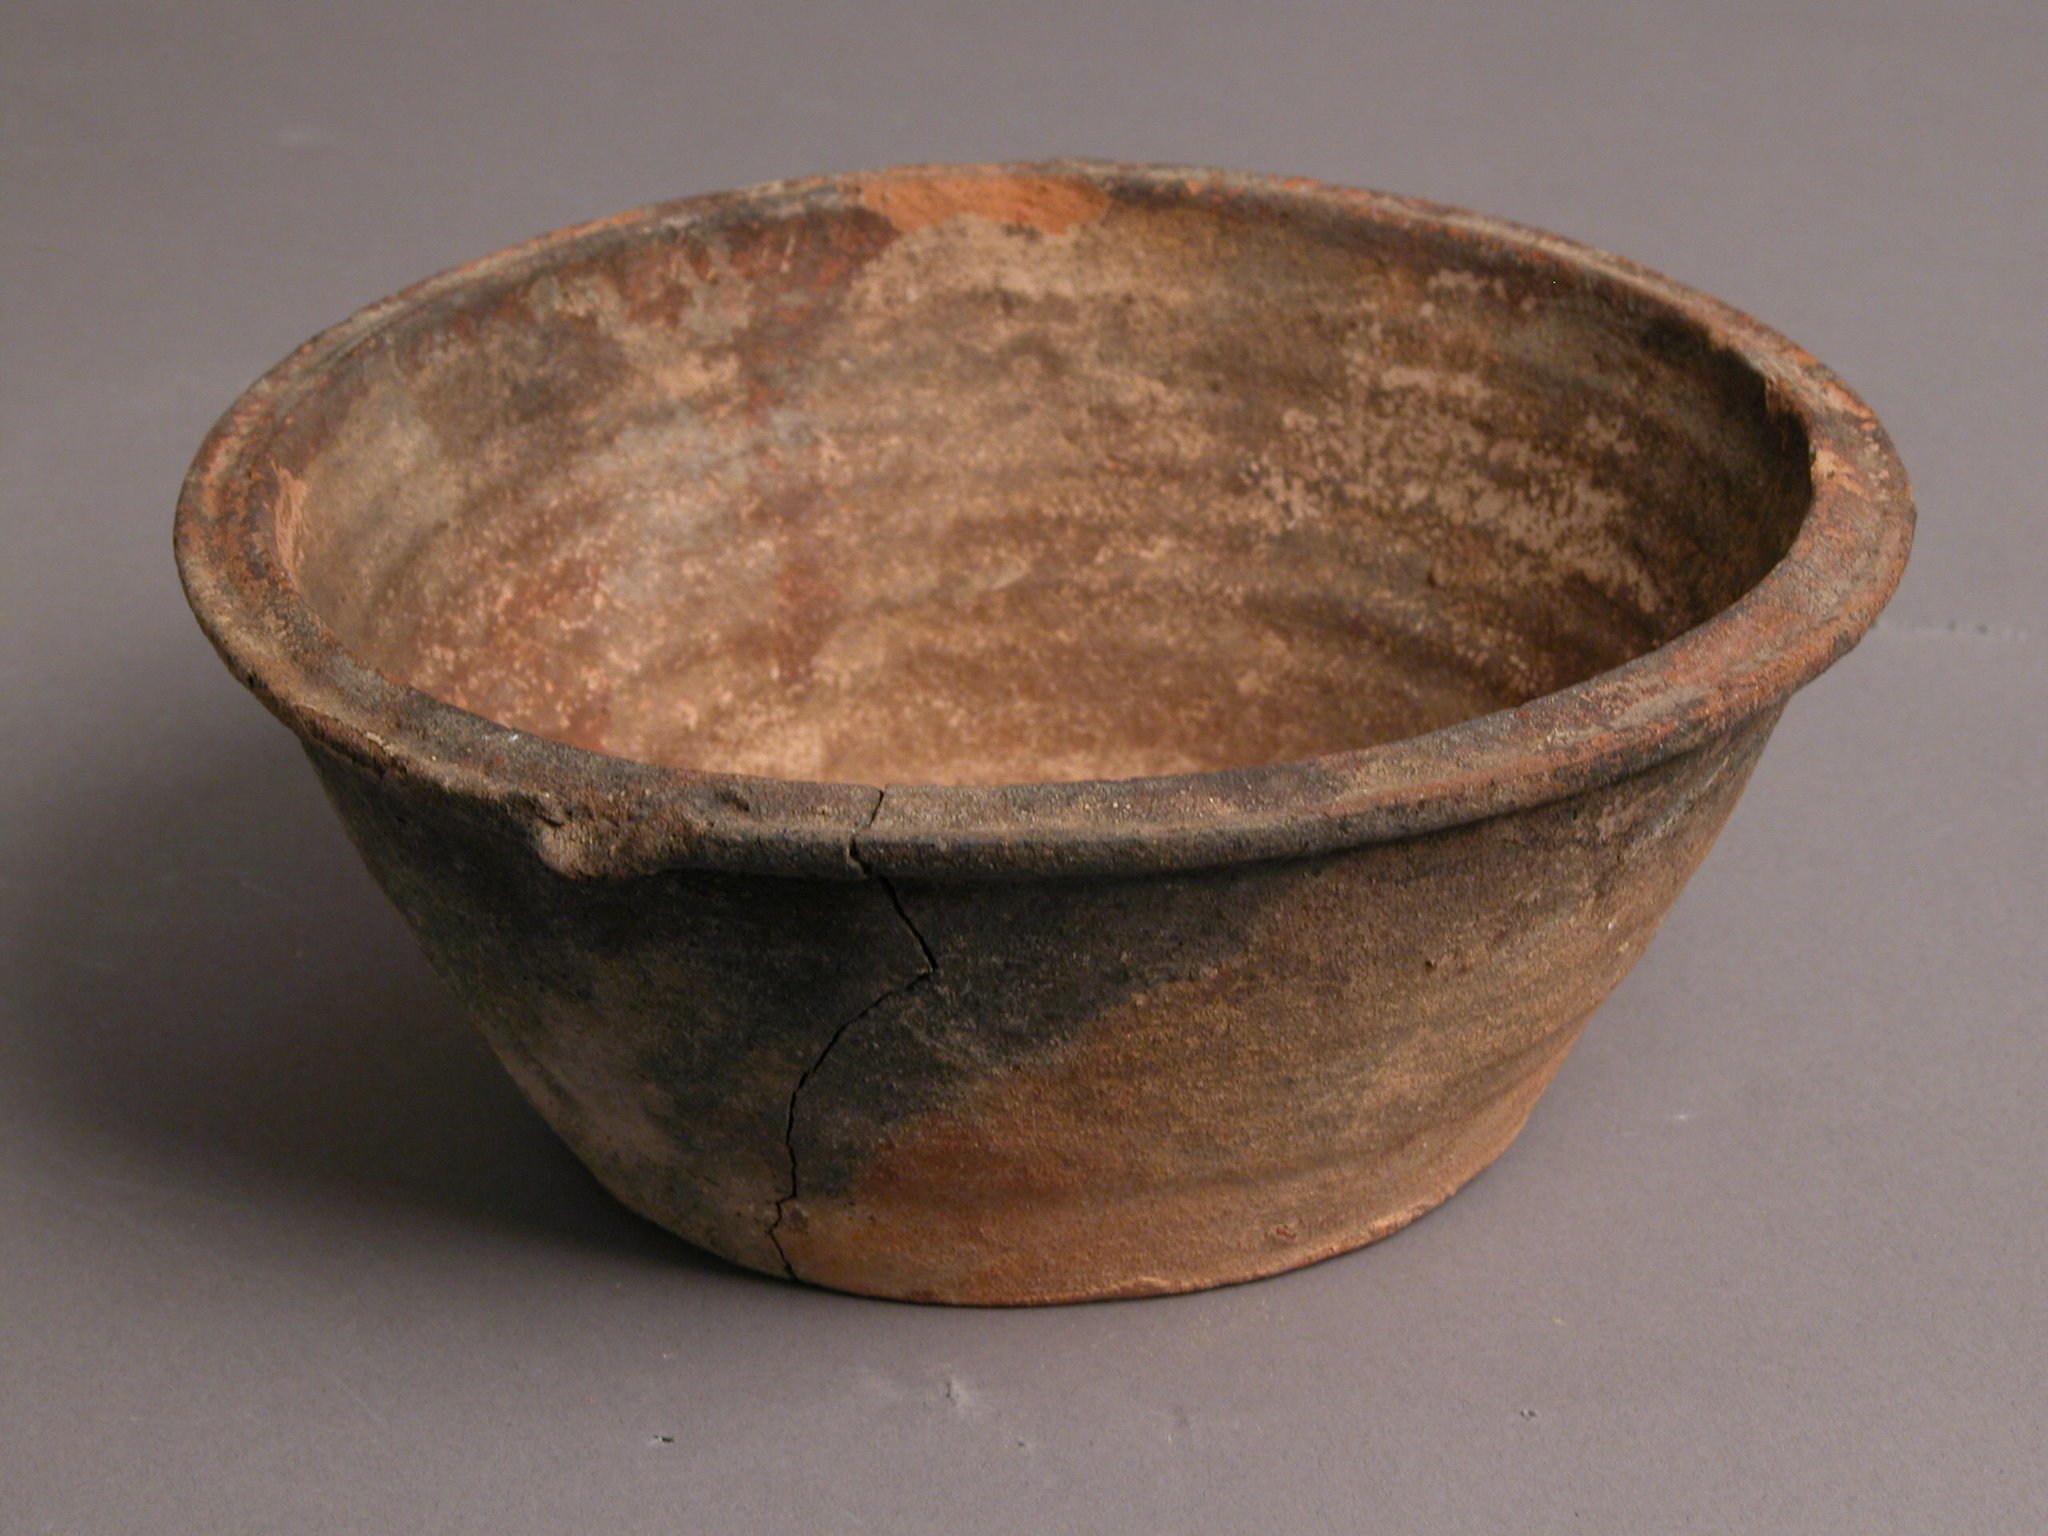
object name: bowl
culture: coptic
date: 301-700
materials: earthenware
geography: egypt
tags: bowls